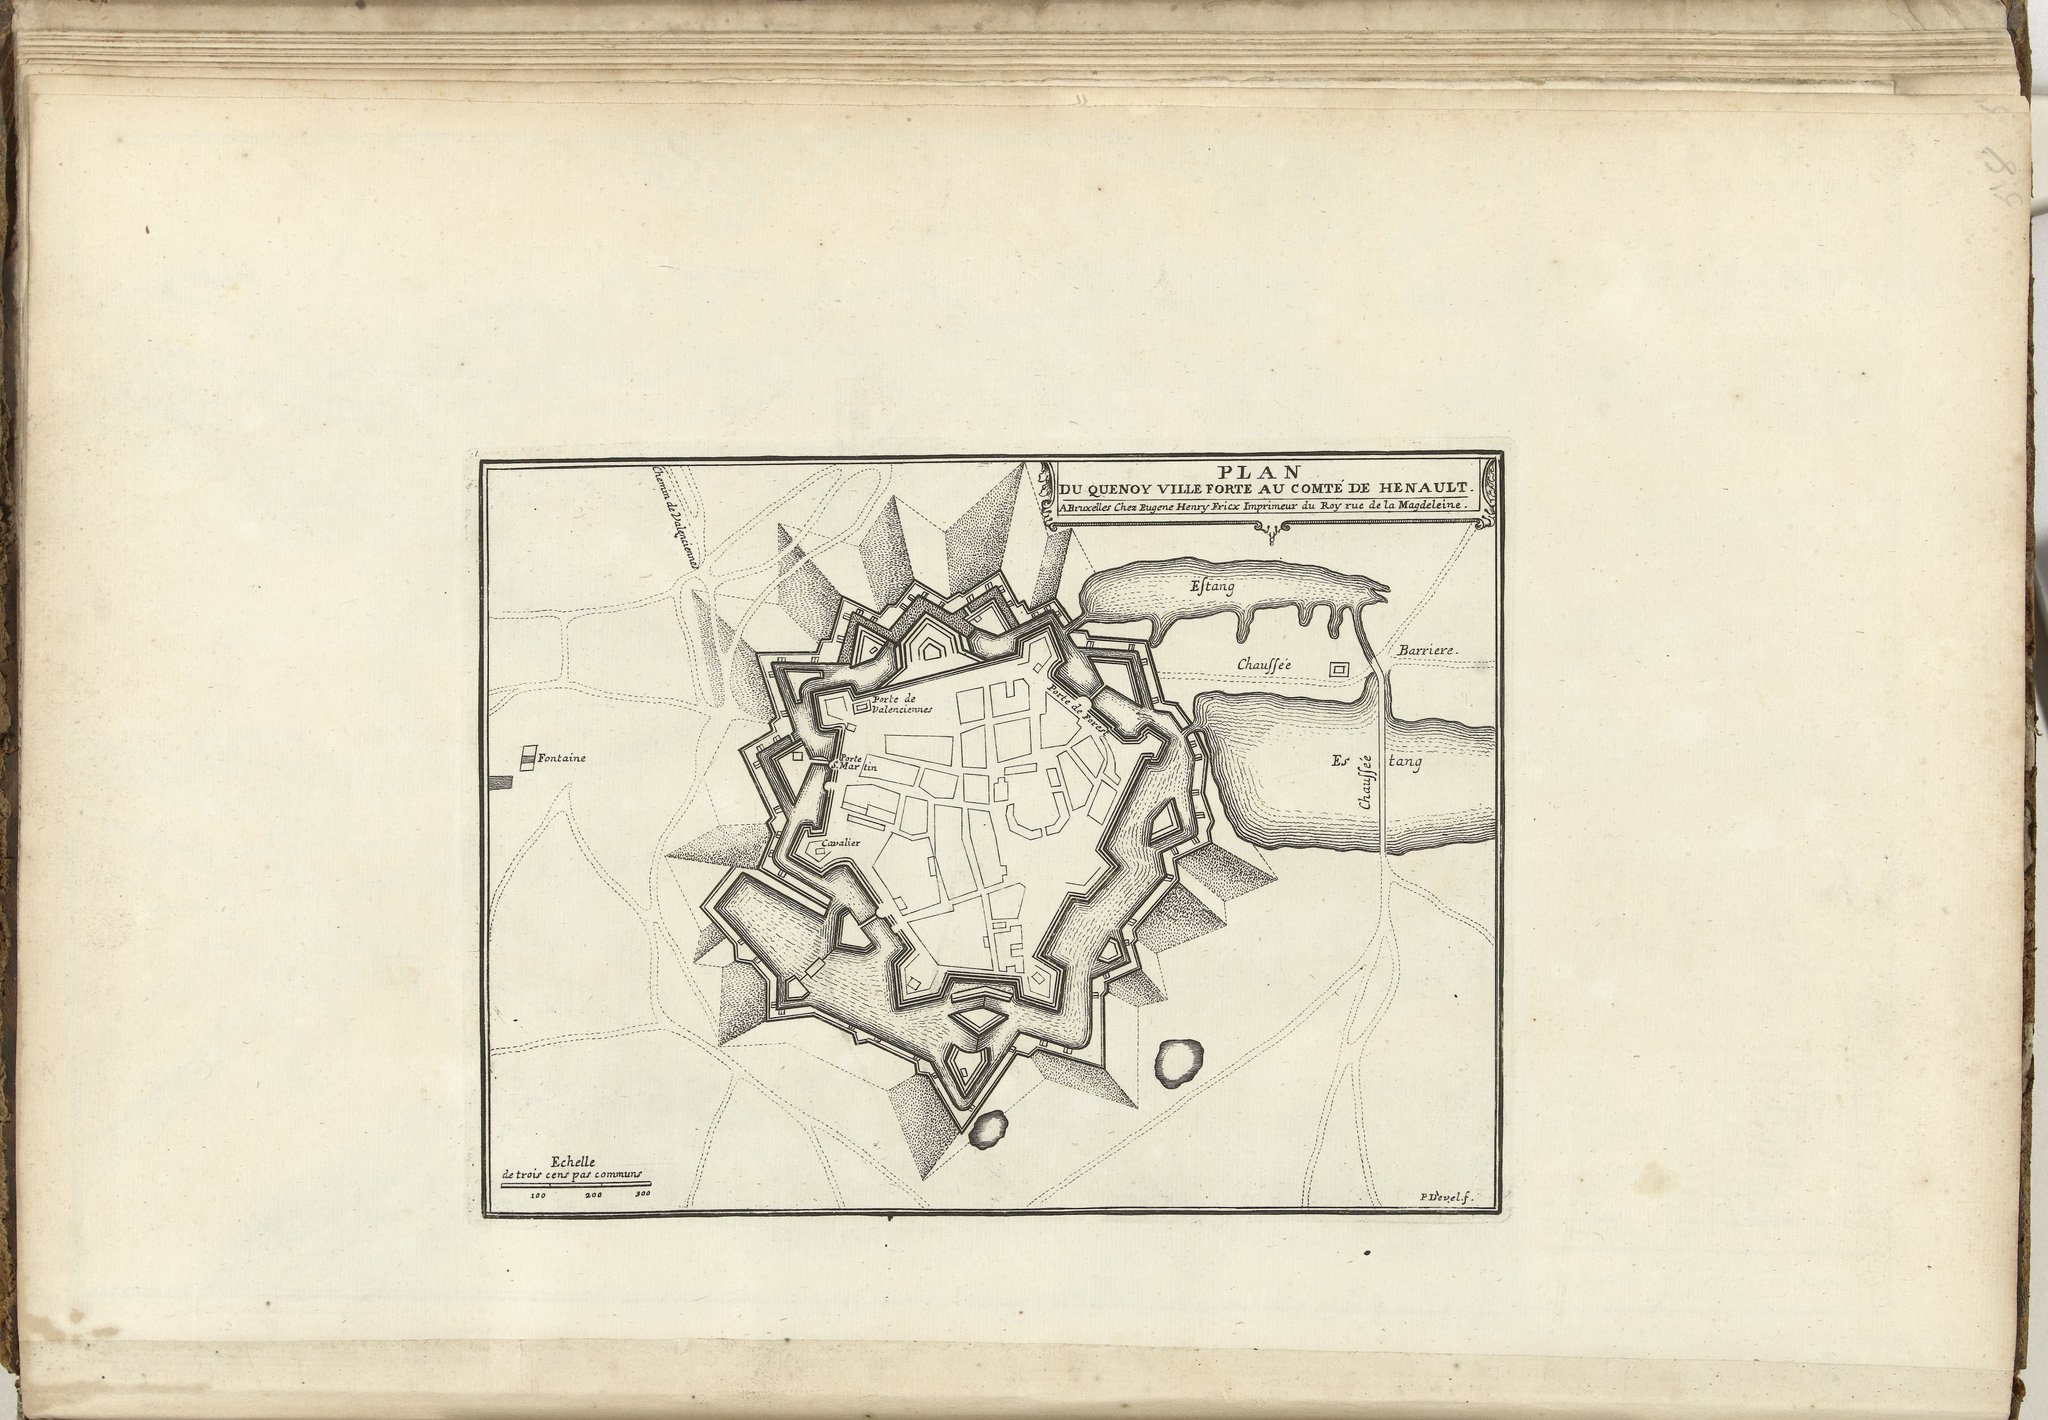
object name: map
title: Plattegrond van le Quesnoy, 1712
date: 1712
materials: paper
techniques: etching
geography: brussels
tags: maps of cities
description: Plattegrond van le Quesnoy, belegerd door de Geallieerden in 1712. Onderdeel van een gebundelde verzameling van plannen van veldslagen en steden vermaard in de Spaanse Successieoorlog.